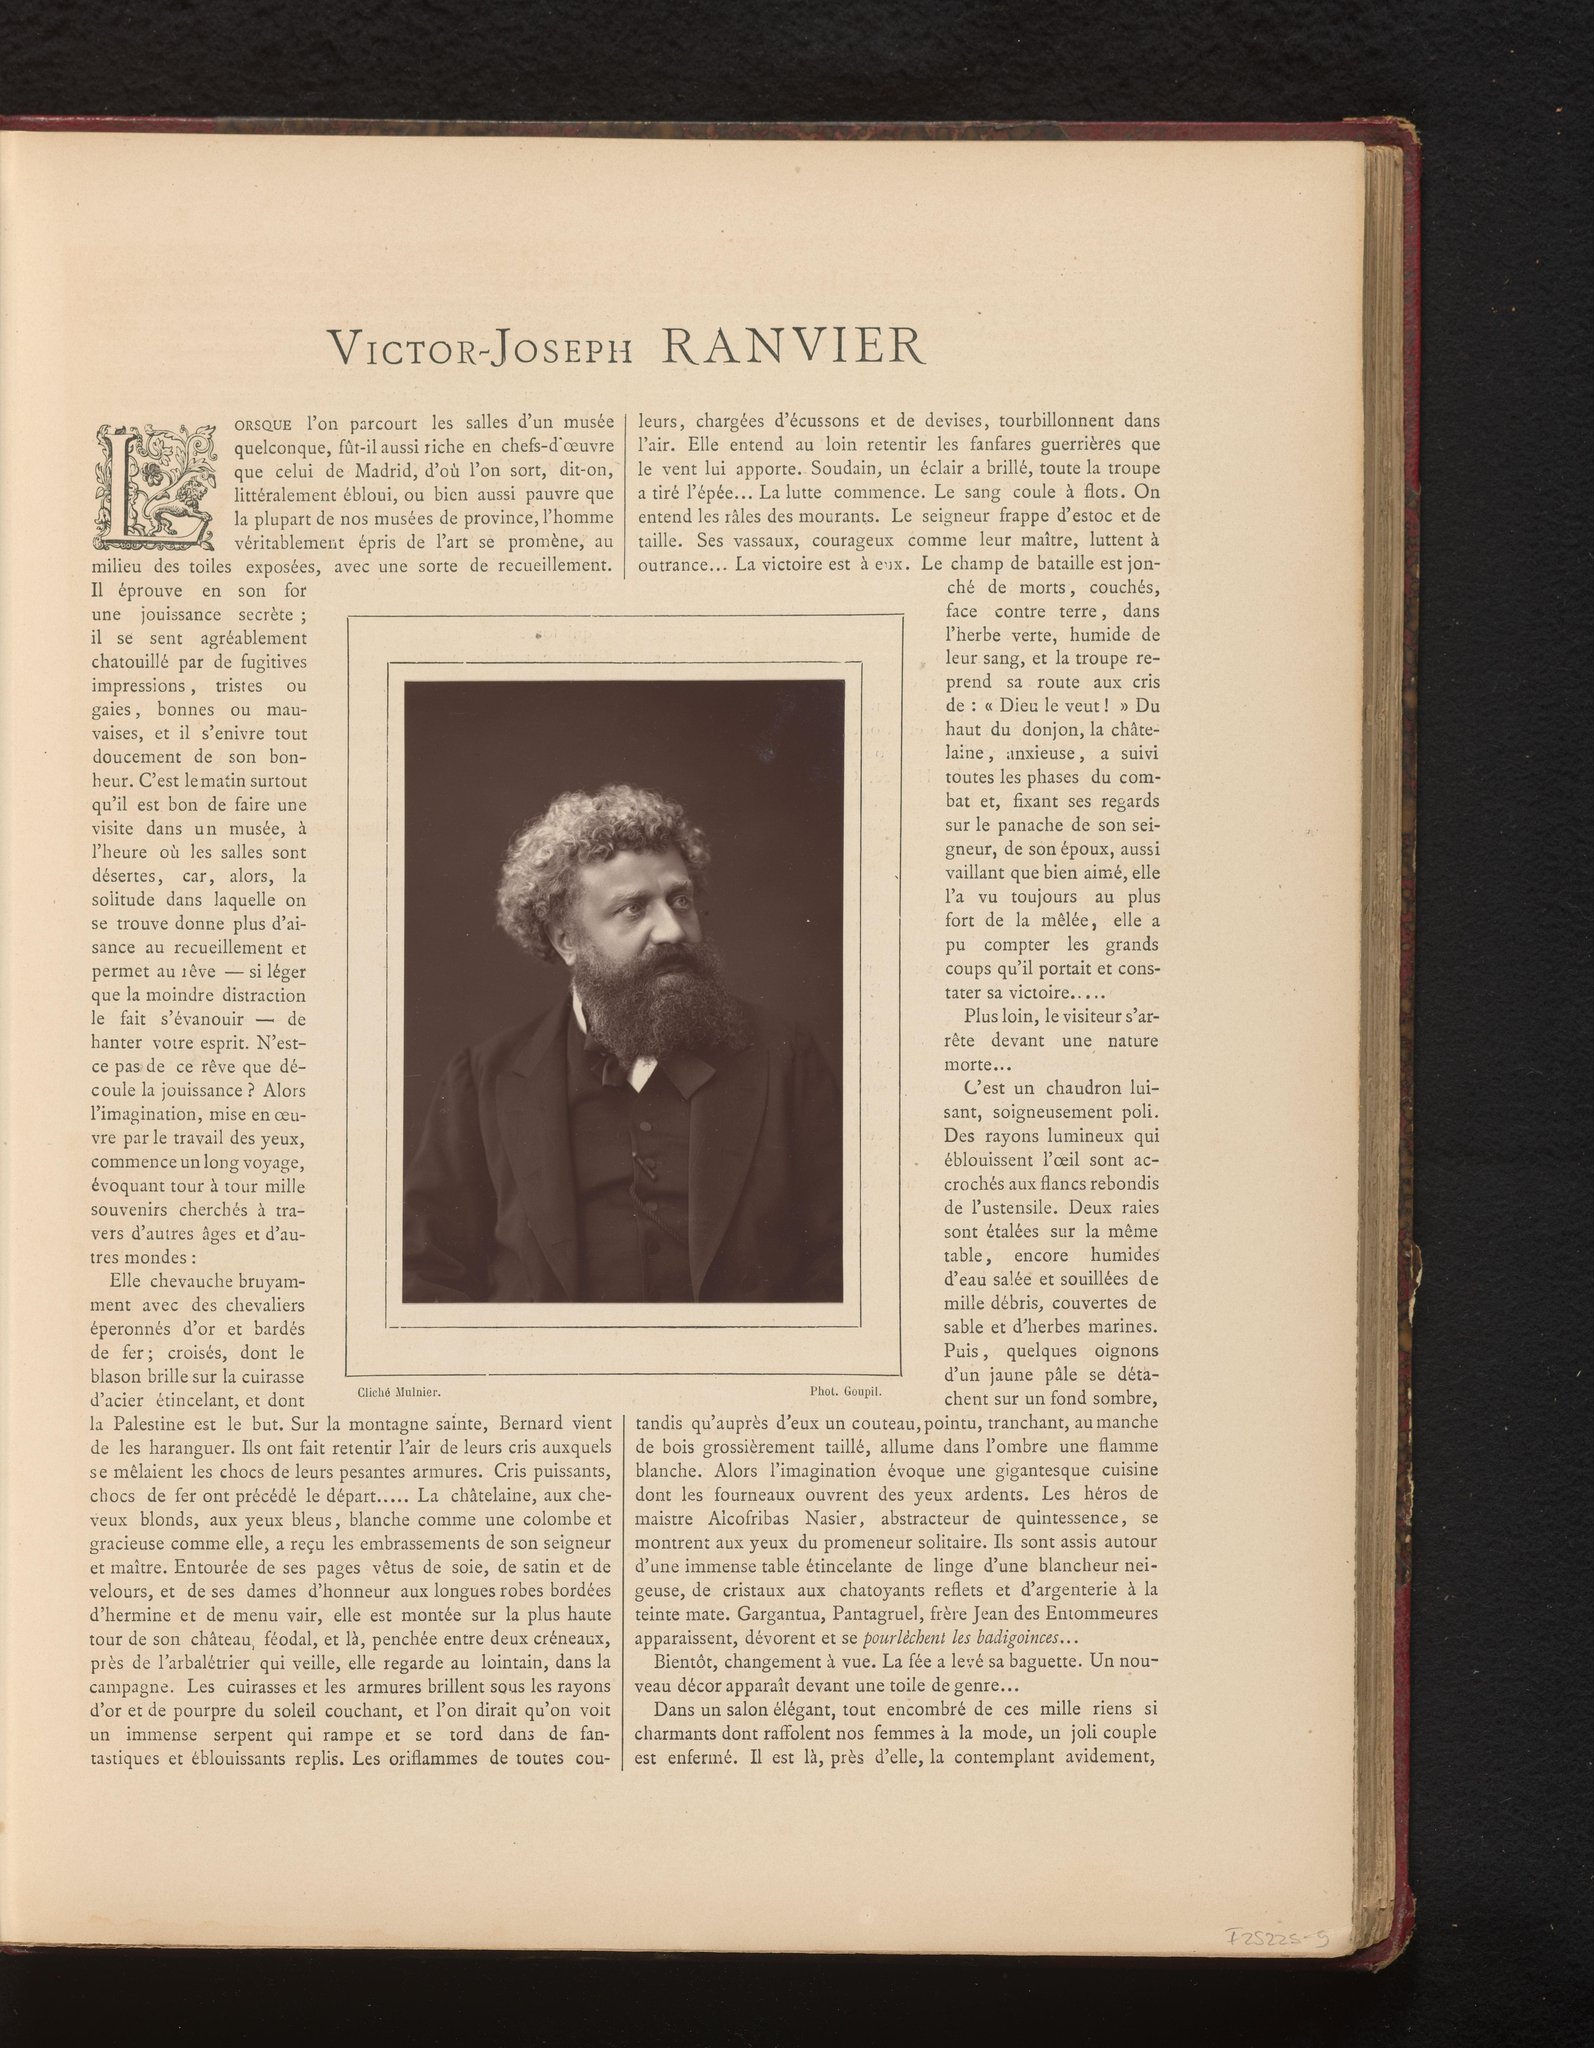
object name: photomechanical print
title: Portret van Joseph-Victor Ranvier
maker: ferdinand mulnier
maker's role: painter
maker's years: 1817-1891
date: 1876-1881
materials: paper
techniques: woodburytype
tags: lyon, painter, joseph-victor ranvier, historical persons